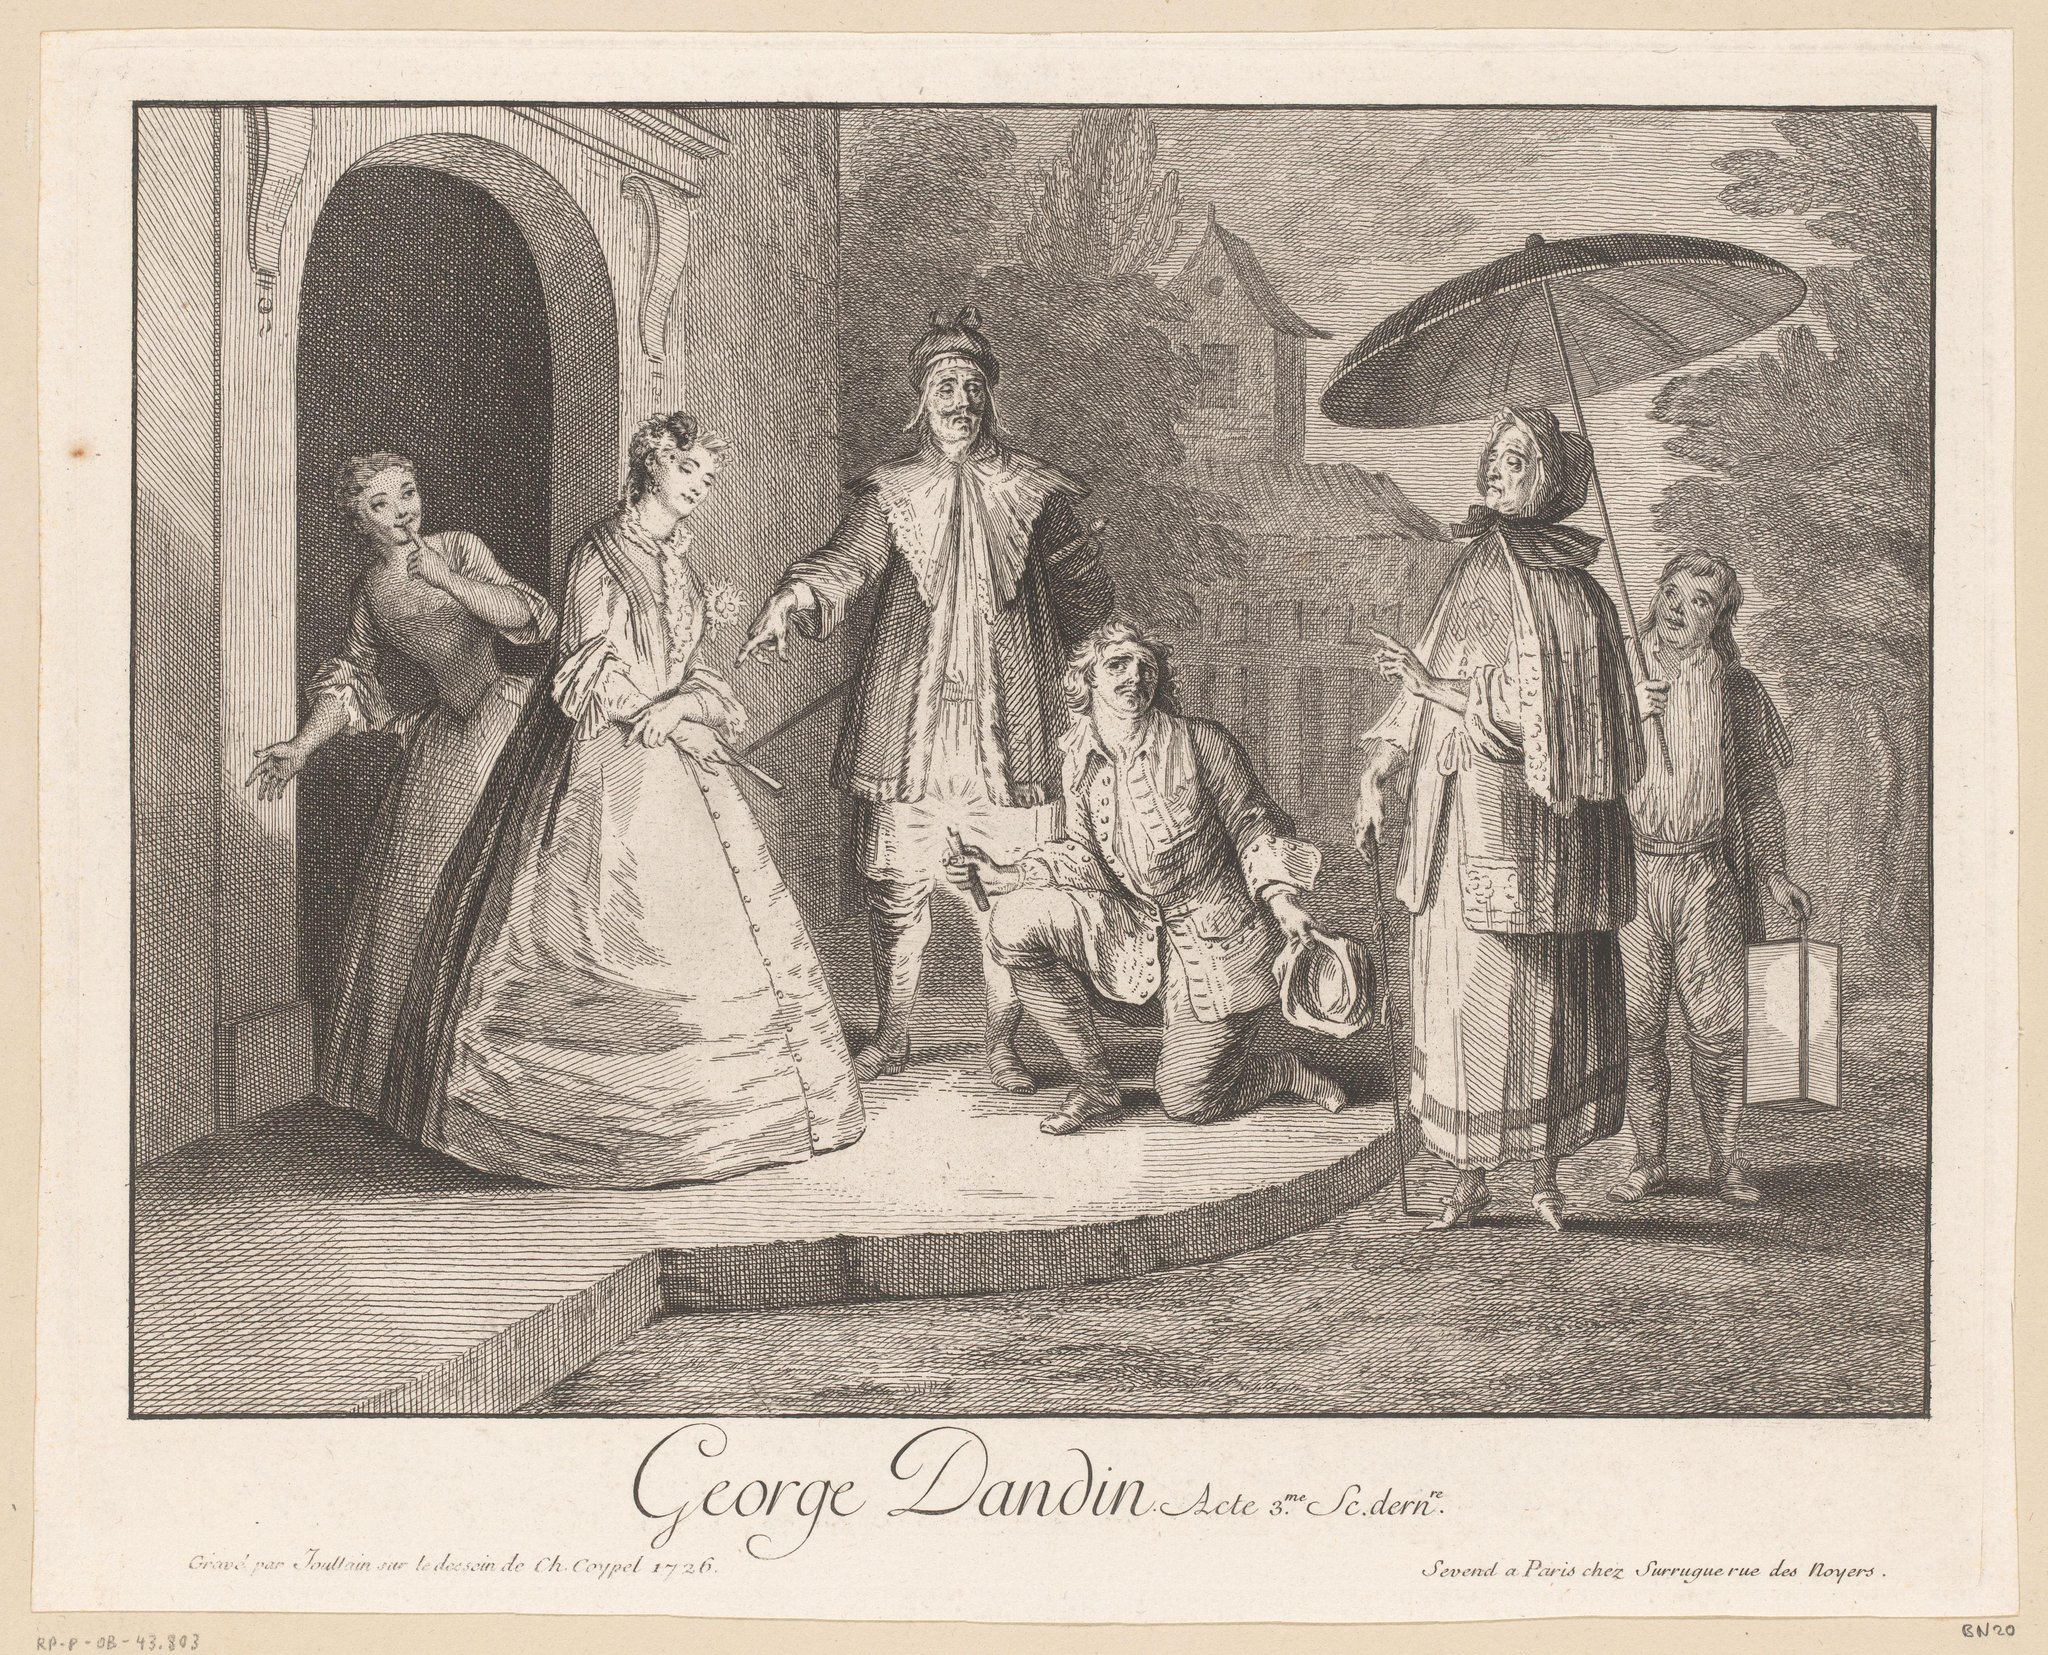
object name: print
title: Prenten naar toneelscènes uit het werk van Molière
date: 1726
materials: paper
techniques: engraving, etching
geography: paris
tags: adult woman, theatre, theatrical performance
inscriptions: collector's mark: Lugt 240